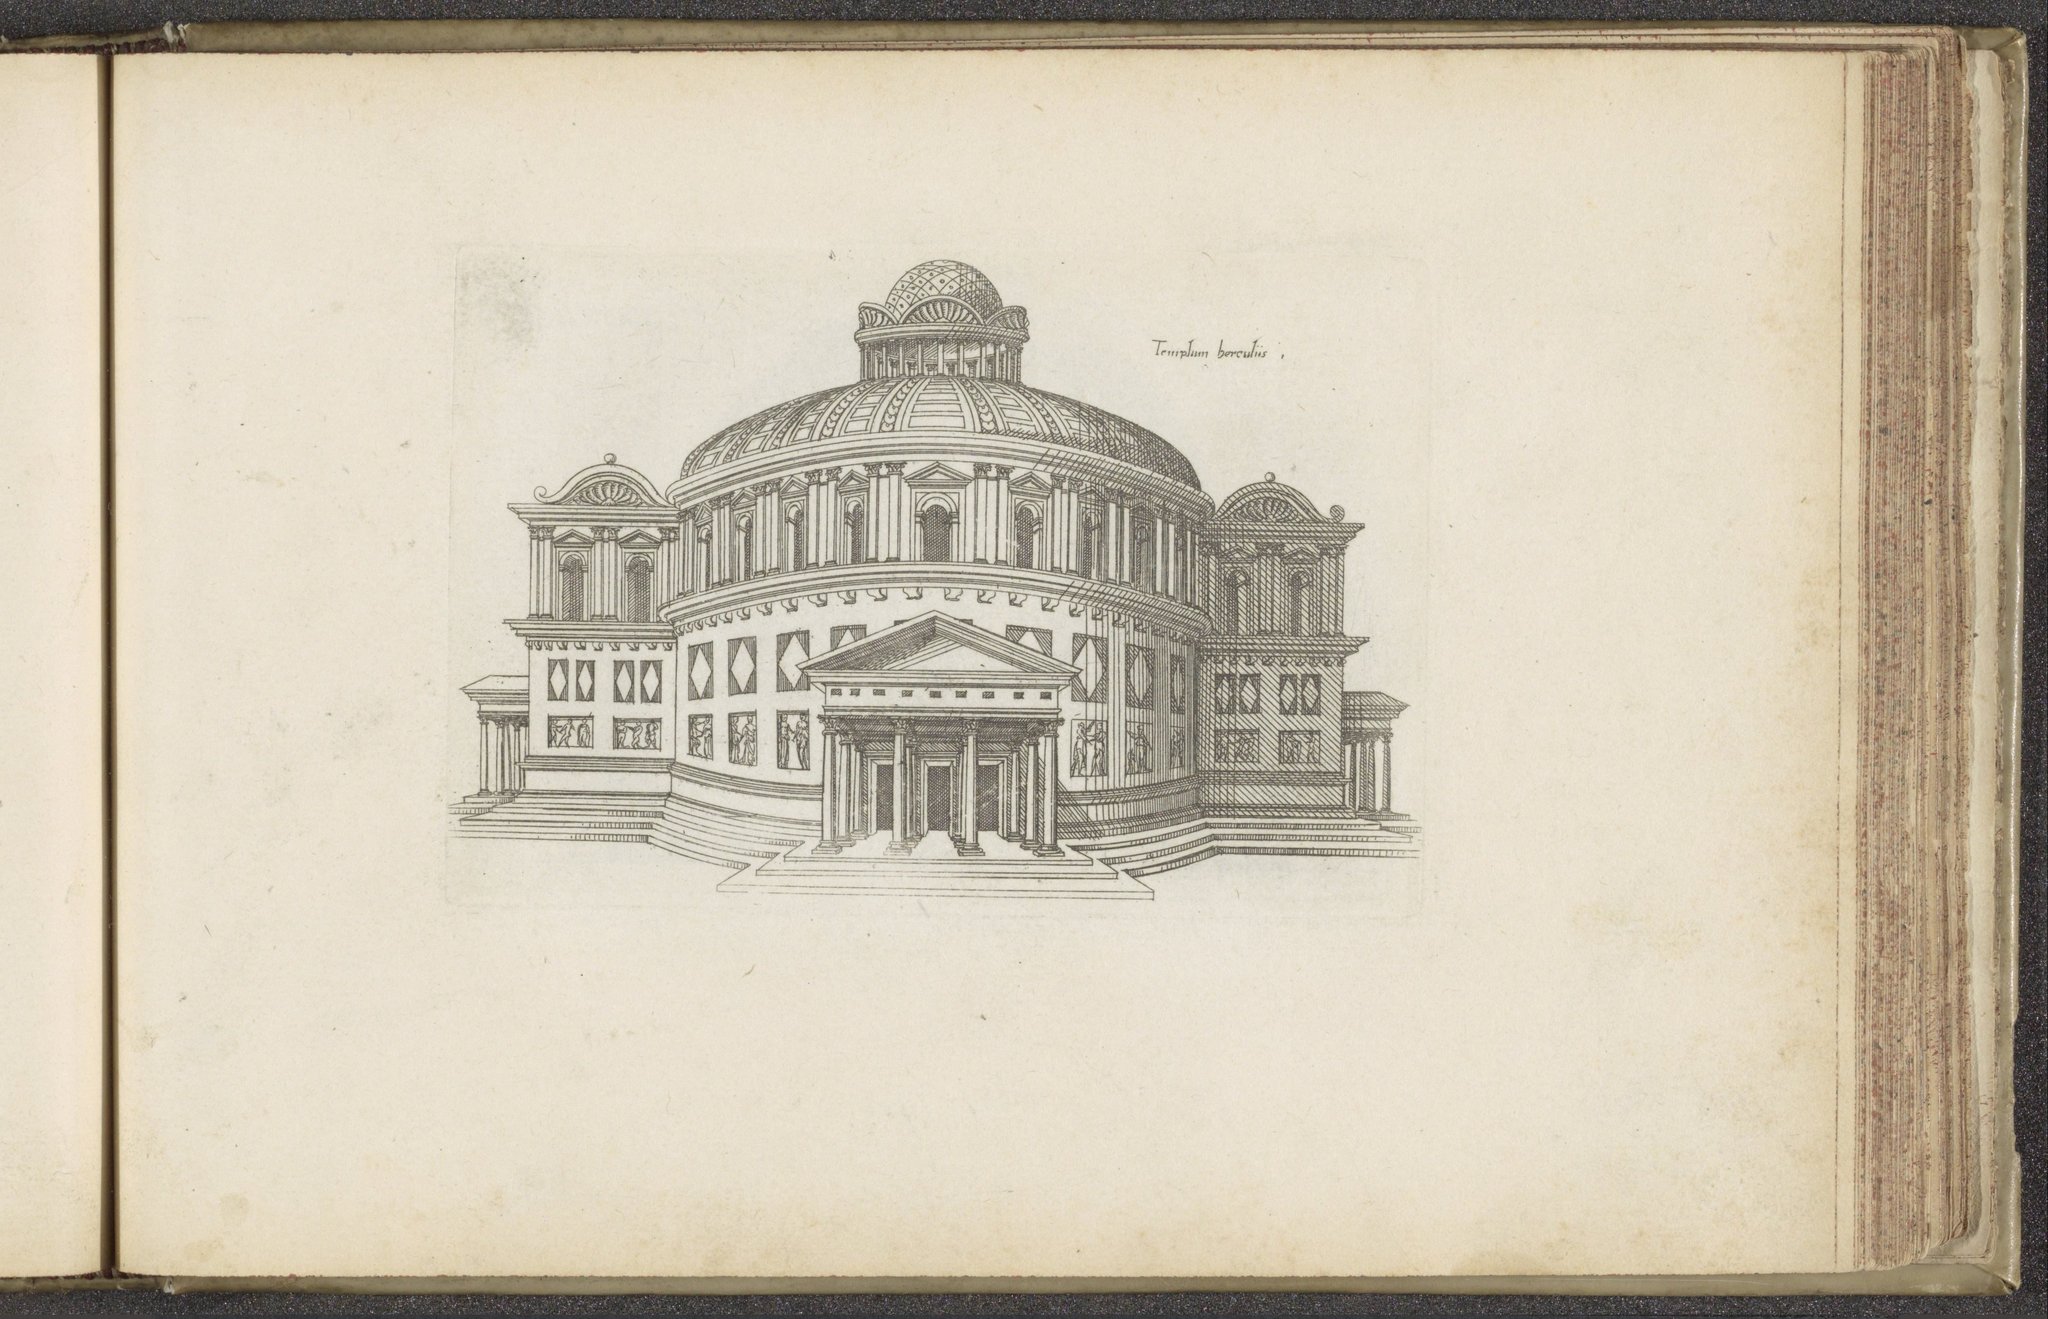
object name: print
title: Iacobus Androuetius Du Cerceau Lectoribus S Quoniam apud veteres alio structurae genere templa (...)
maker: jacques androuet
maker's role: draughtsman, print maker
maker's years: 1515-1584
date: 1550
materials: paper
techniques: etching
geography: orléans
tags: temple, shrine ~ roman religion, exterior ~ representation of a building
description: Ronde tempel van Hercules. Deze prent maakt deel uit van een album.